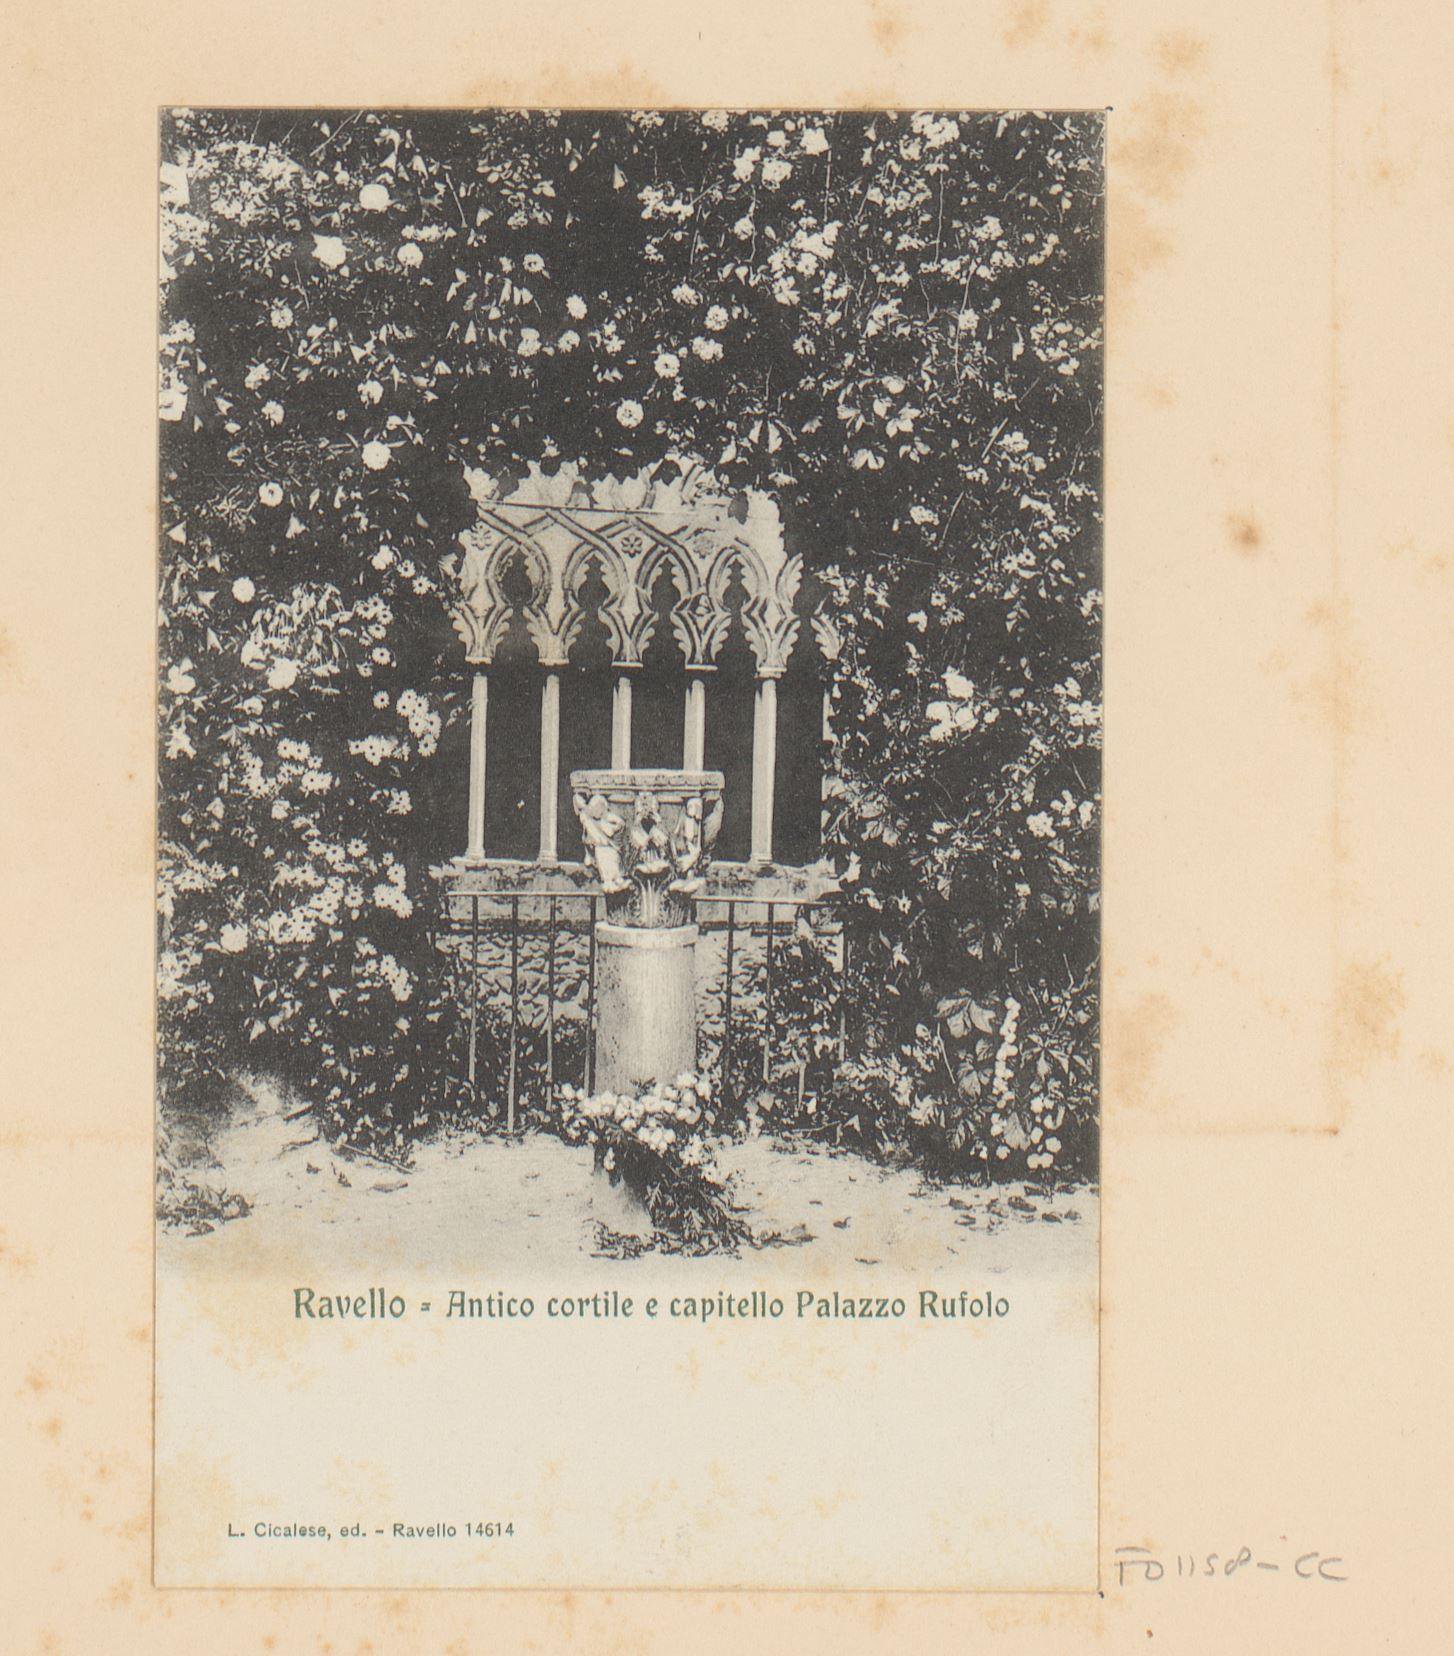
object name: photomechanical print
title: Binnenplaats van de Villa Rufolo te Ravello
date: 1875-1907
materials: paper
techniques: photograph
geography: ravello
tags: column, pillar ~ architecture, façade (of house or building)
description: Onderdeel van Fotoalbum met opnames van bezienswaardigheden en kunstwerken in Italië.